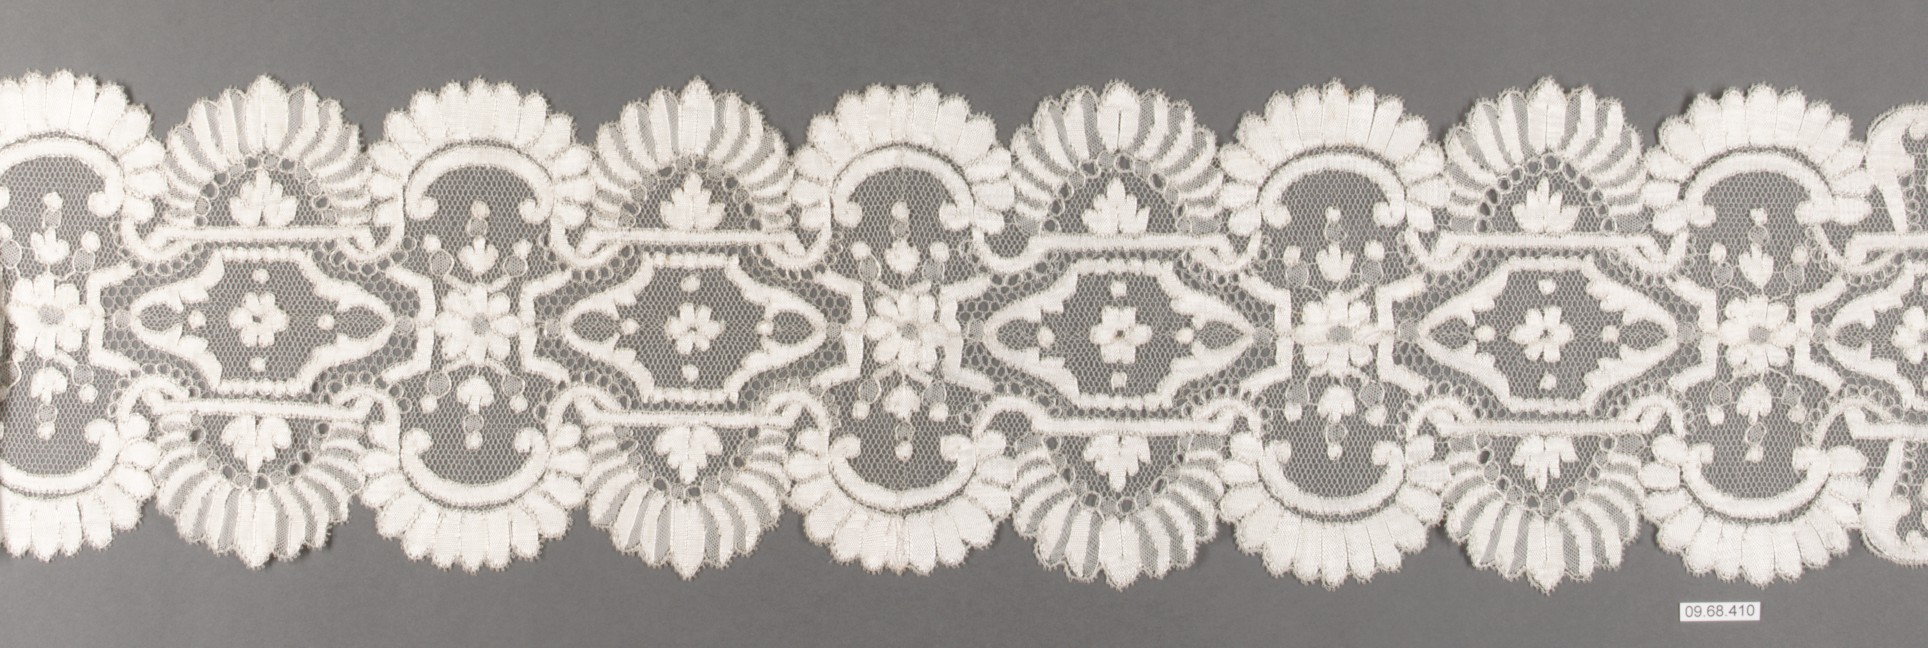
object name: lappet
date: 1801-1900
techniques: lace